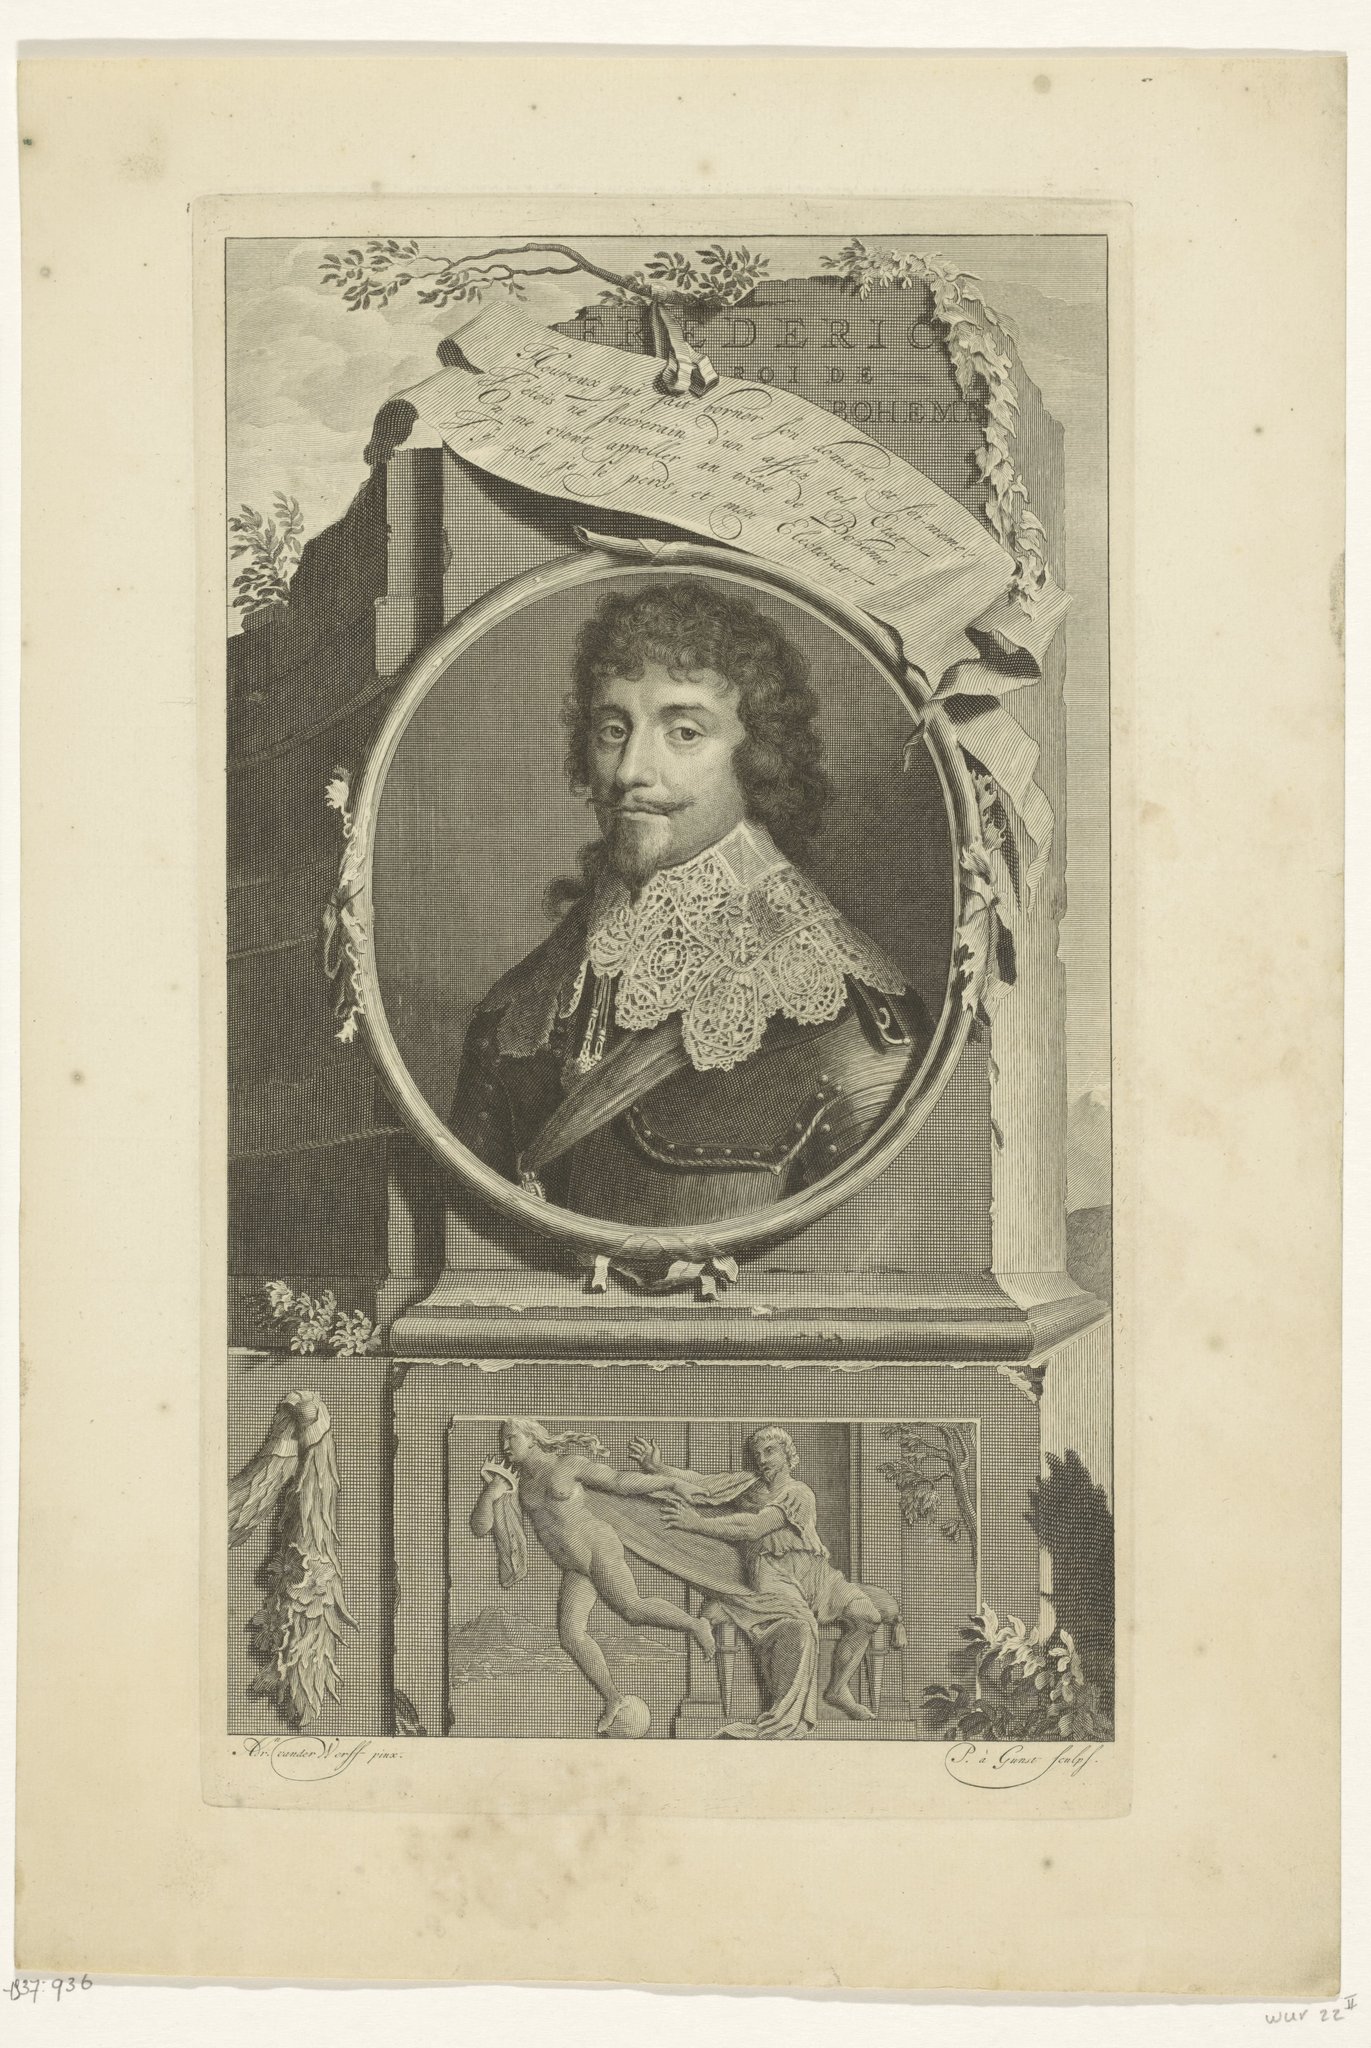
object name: print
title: Portret van Frederik V, keurvorst van de Palts, koning van Bohemen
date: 1669-1731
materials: paper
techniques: engraving, etching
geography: amsterdam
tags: amberg, frederik v (keurvorst van de palts, koning van bohemen), landscape with ruins, luck, fortune, lot; 'fato', 'fortuna', 'fortuna aurea', 'fortuna buona', 'fortuna pacifica overo clemente', 'sorte' (ripa)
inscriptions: collector's mark: Lugt 2228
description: Frederik V, keurvorst van de Palts, koning van Bohemen. Boven de prent een banderol met een Frans gedicht over zijn leven. Onder de prent een voorstelling van landschap met klassieke ruïnes met op de voorgrond de personificatie Fortuna die de kroon steelt van Frederik V.